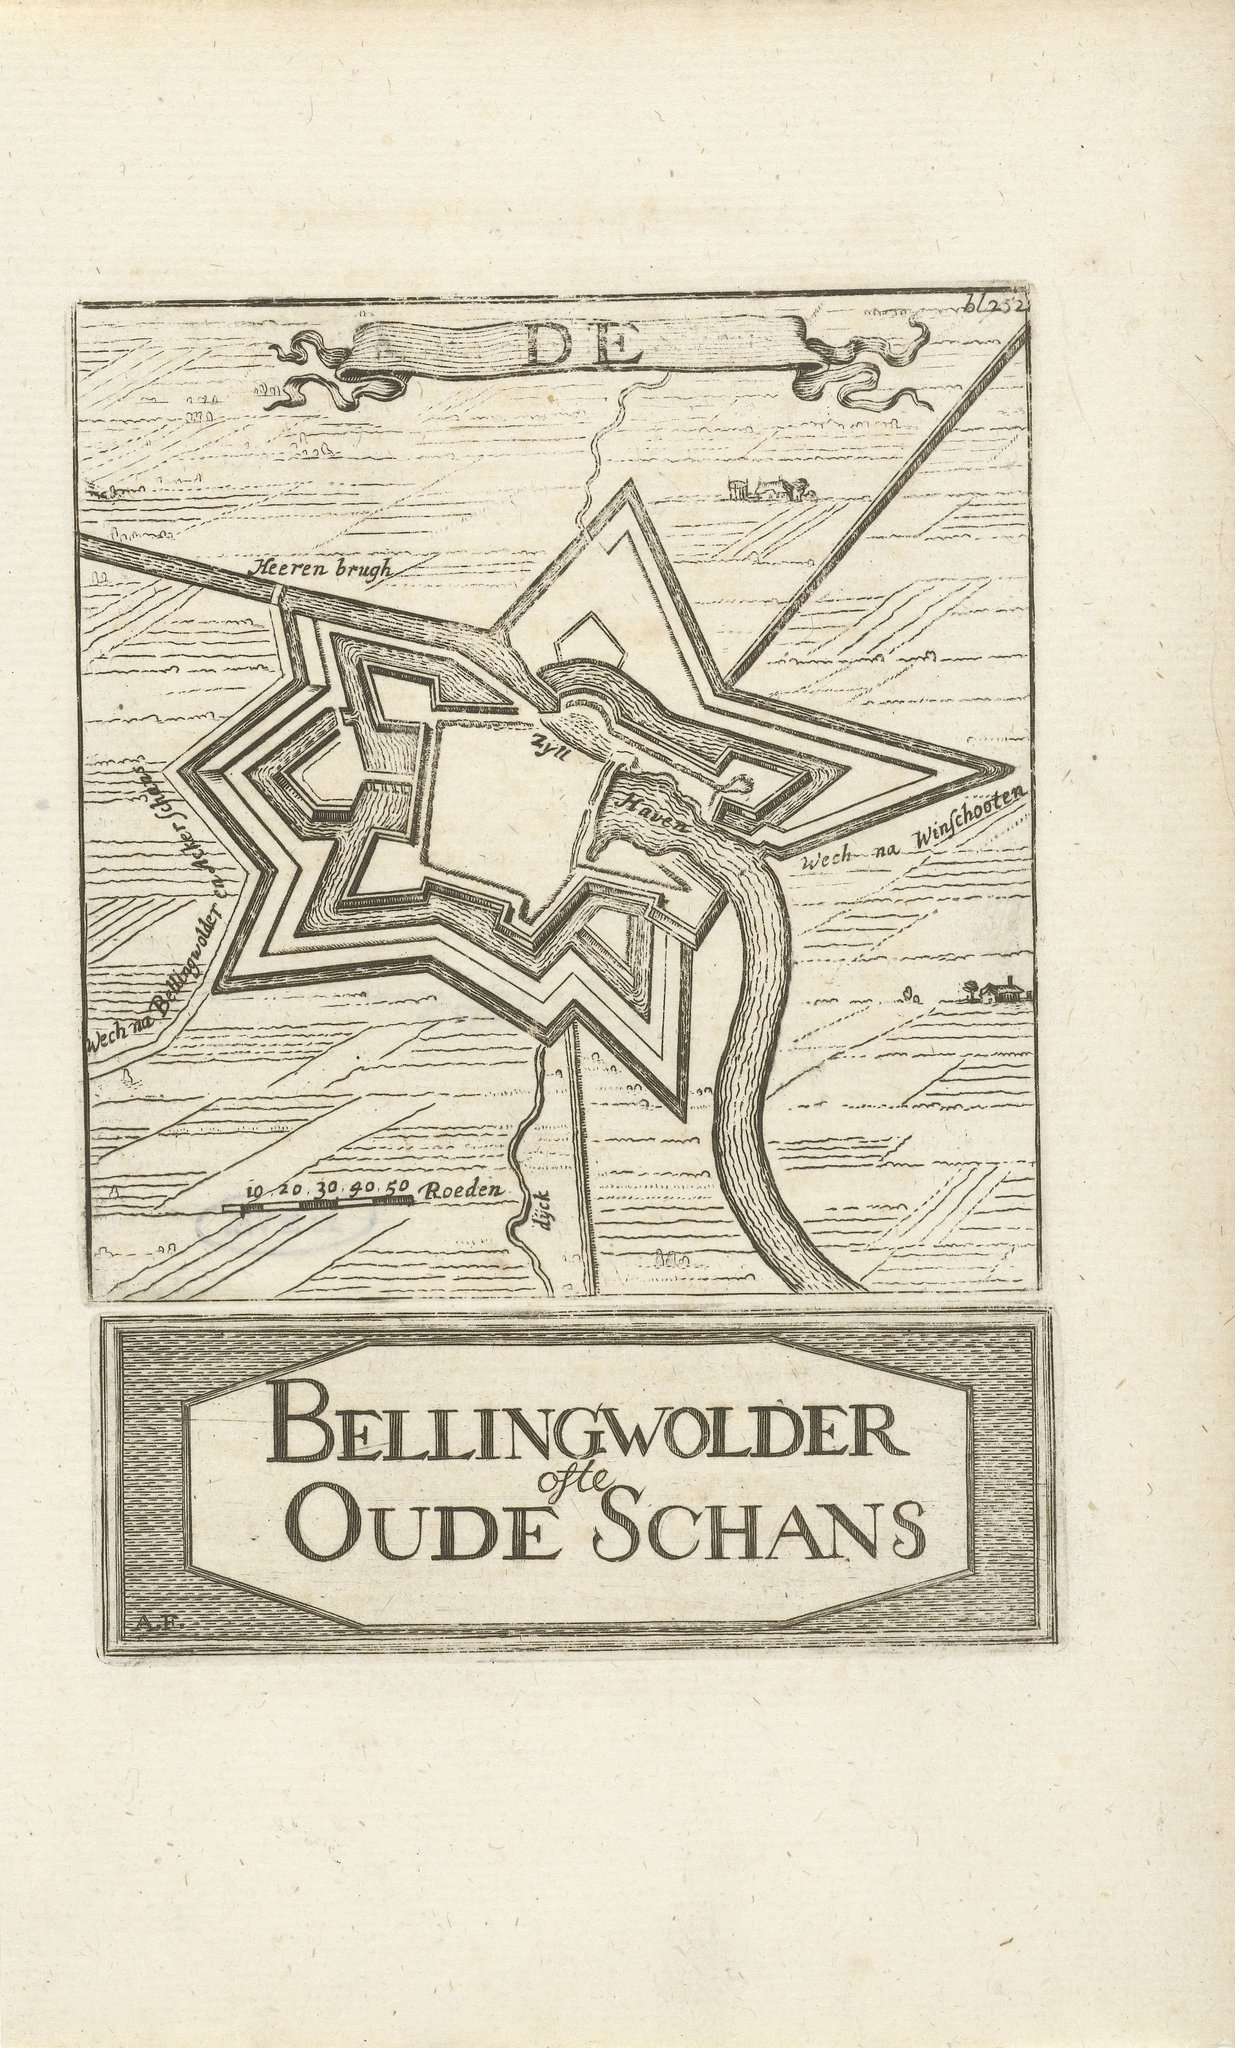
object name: print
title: Kaart van Bellingwolde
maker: hendrik hofsnider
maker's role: print maker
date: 1743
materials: paper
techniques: etching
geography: groningen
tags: maps, atlases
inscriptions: collector's mark: Lugt 2760, collector's mark: Lugt 2228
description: Twee afdrukken op één blad: Bovenaan een afdruk met een voorstelling van een kaart van Bellingwolde en daaronder een afdruk met de titel in een cartouche. In de bovenste afdruk bovenaan een deel van de titel op een lint, linksboven een schaal en: bl. 243.